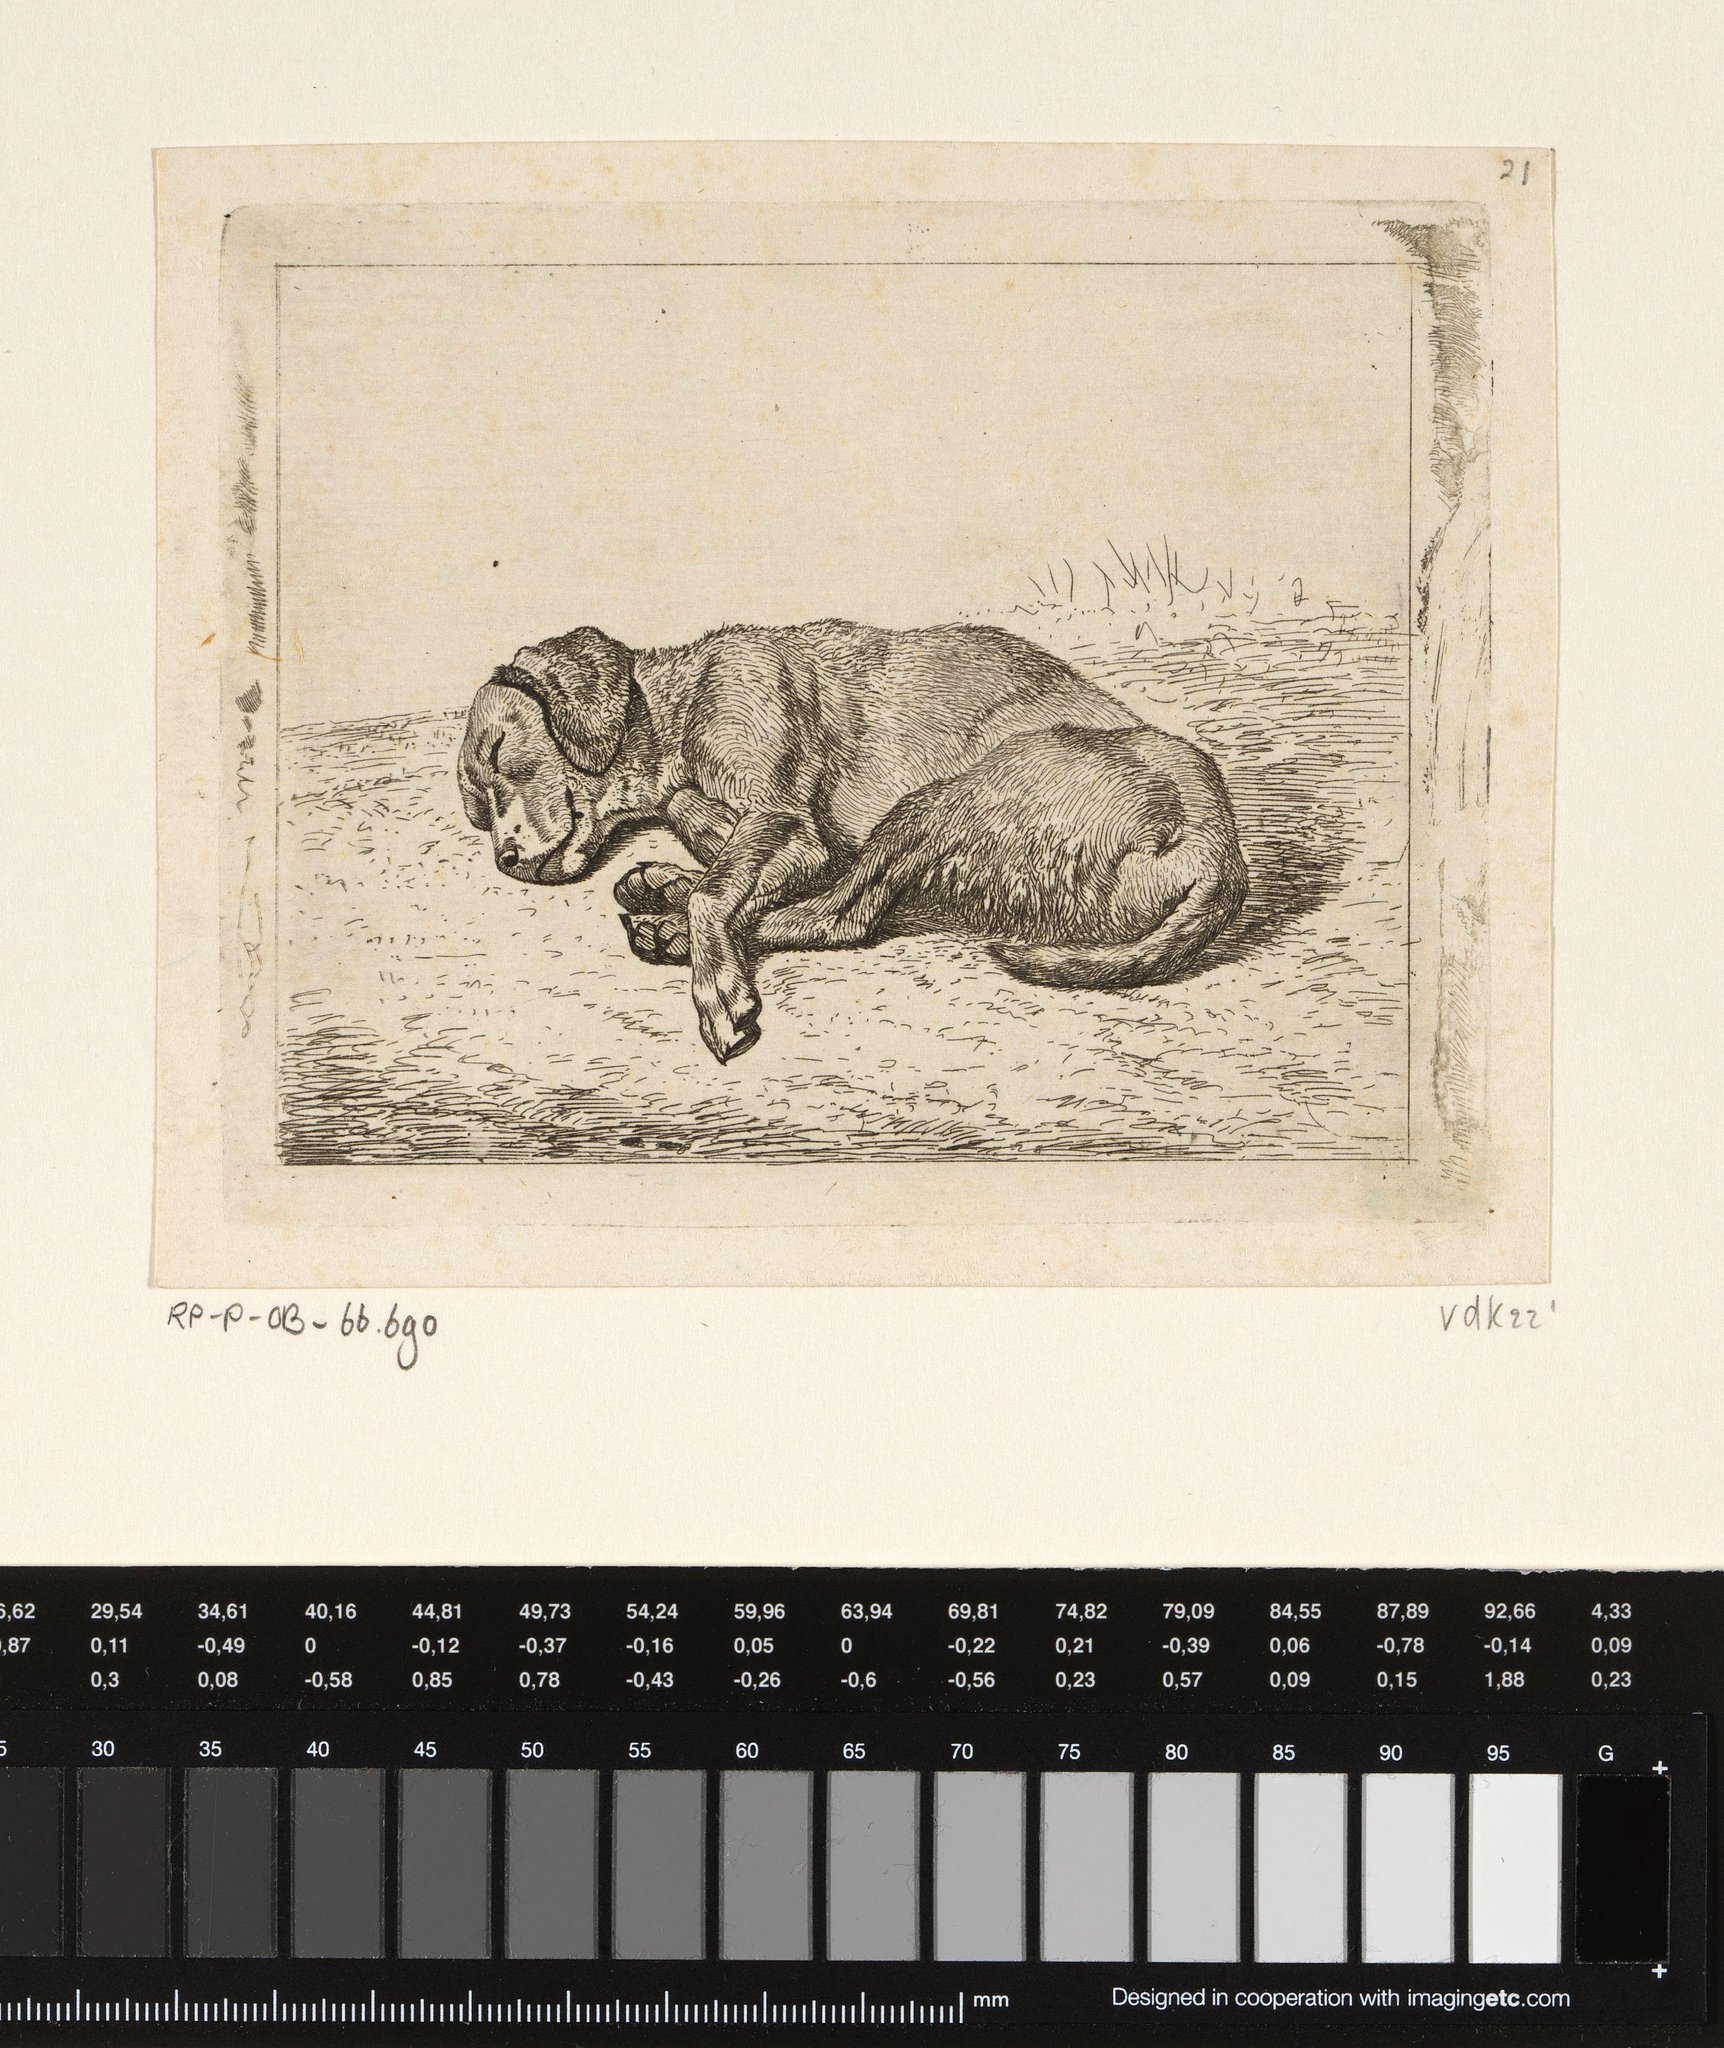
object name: print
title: Slapende hond naar links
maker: wouter johannes van troostwijk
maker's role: draughtsman, painter, print maker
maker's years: 1782-1810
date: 1808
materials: paper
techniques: etching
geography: amsterdam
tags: dog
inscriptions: collector's mark: Lugt 2165